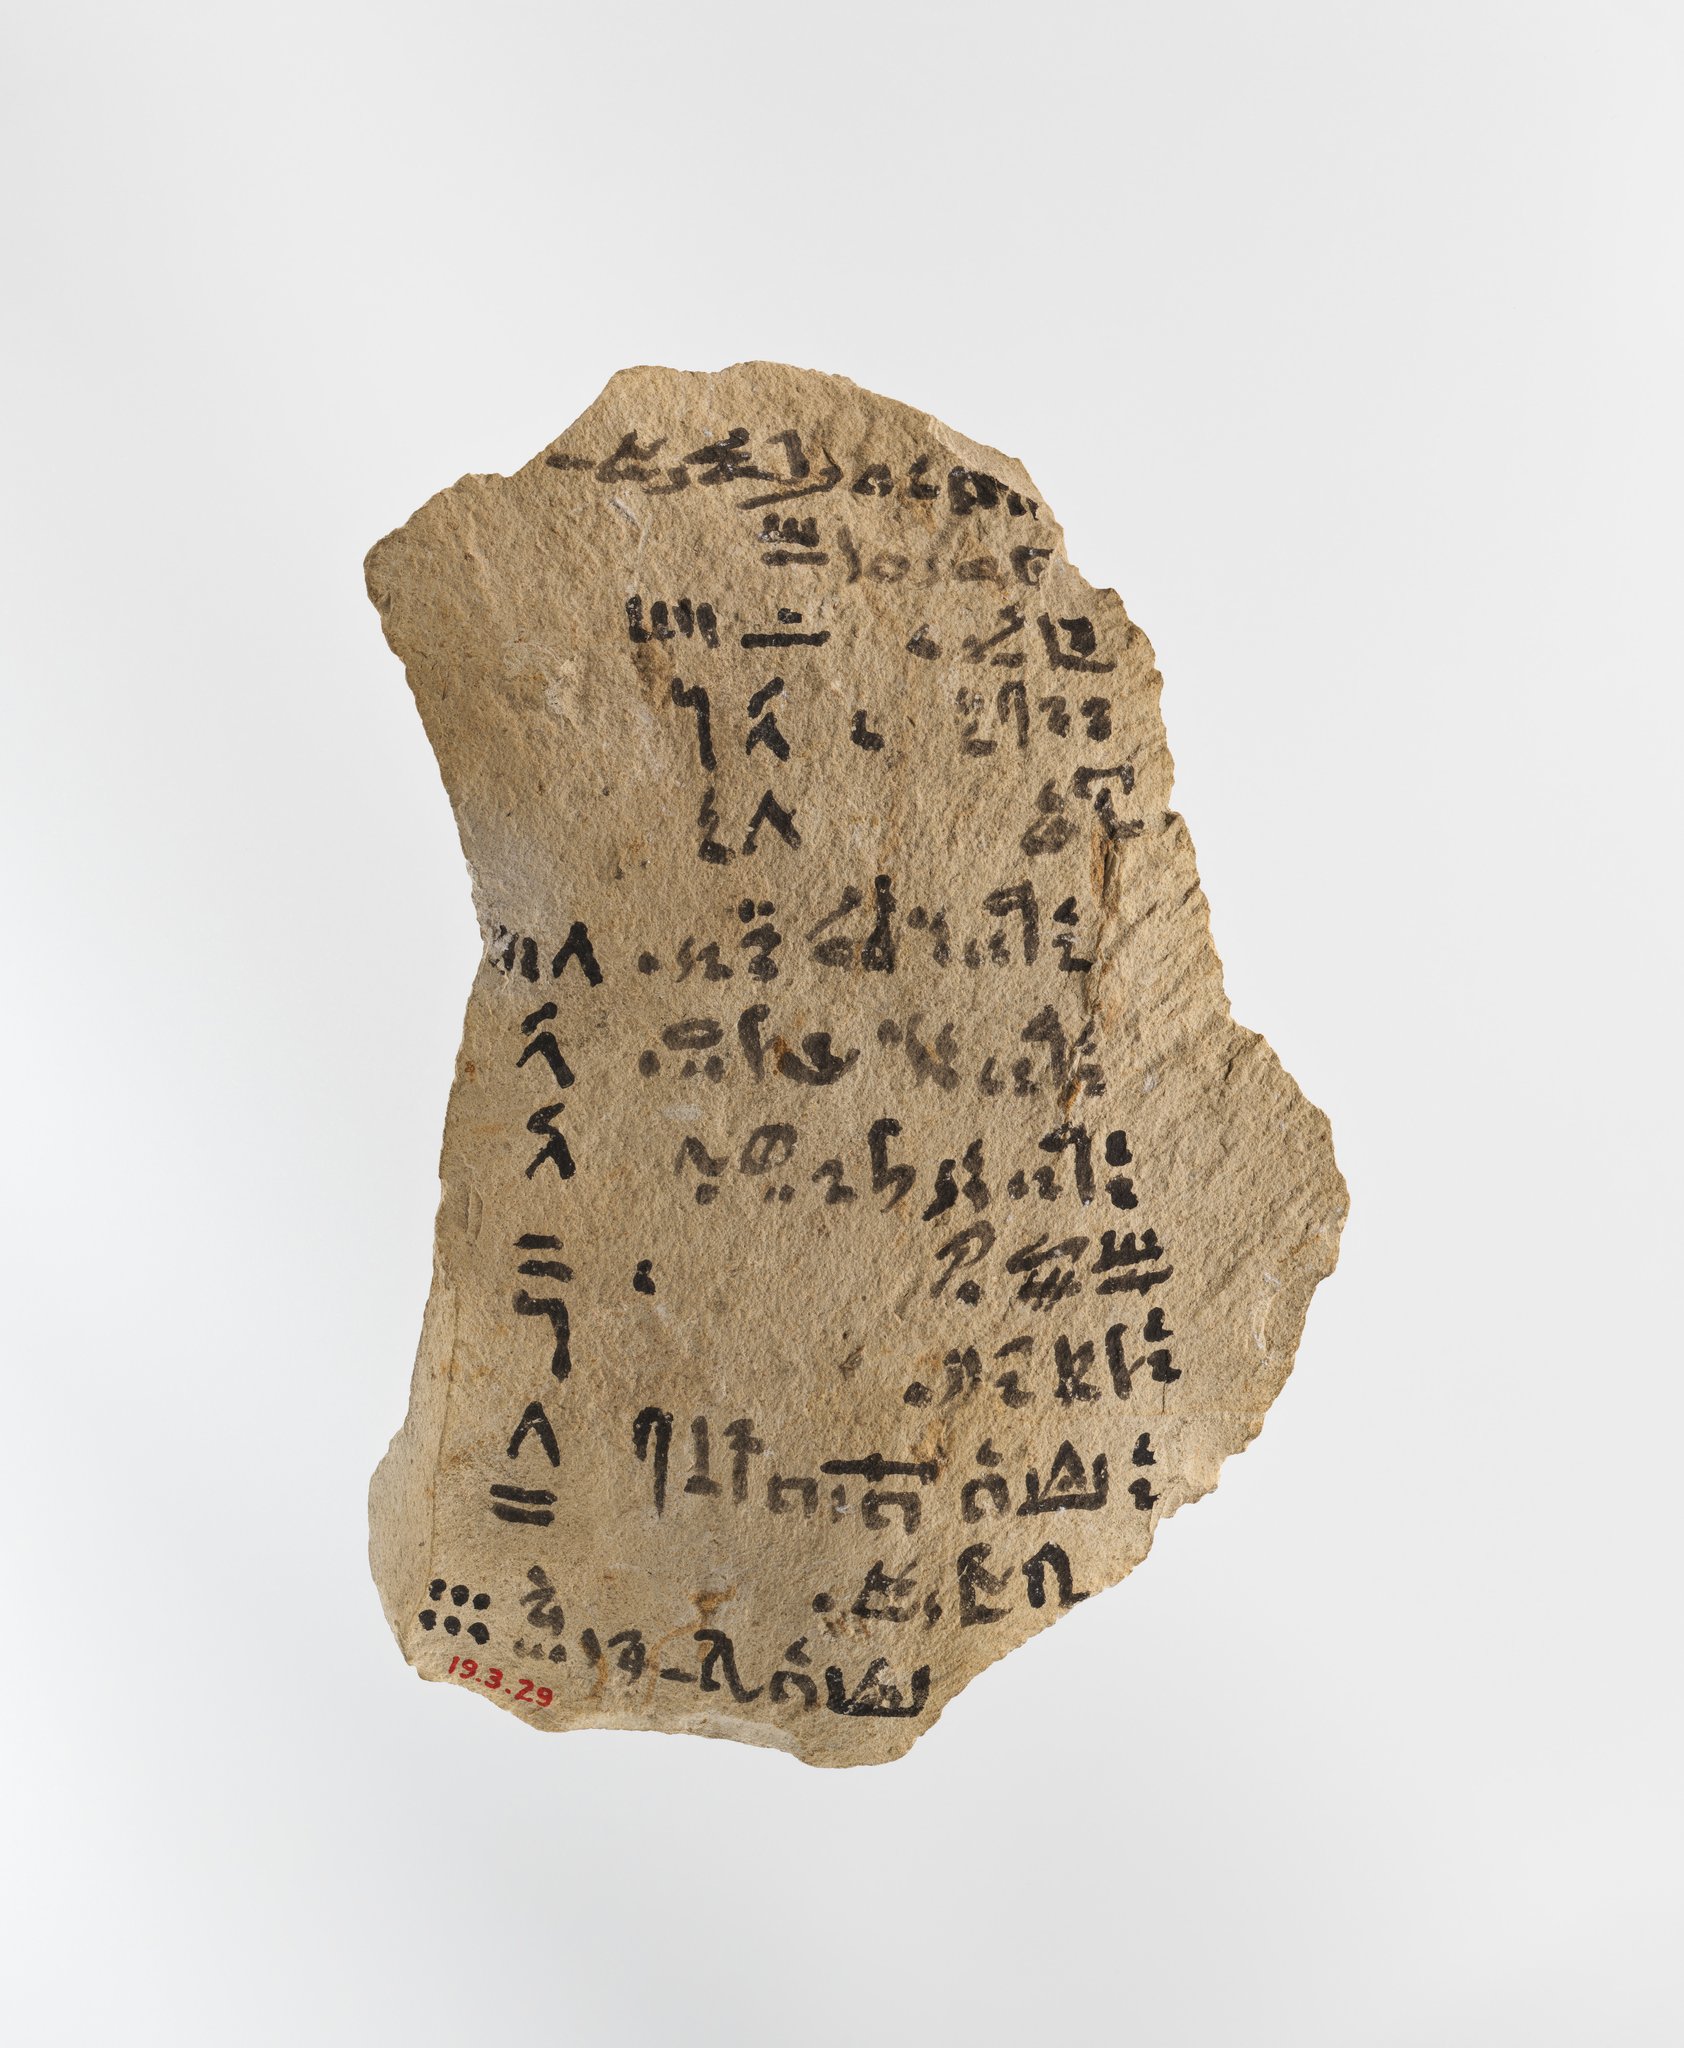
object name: ostracon, hieratic, account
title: Ostracon with hieratic inscription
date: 1295-525 BCE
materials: ink, limestone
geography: egypt